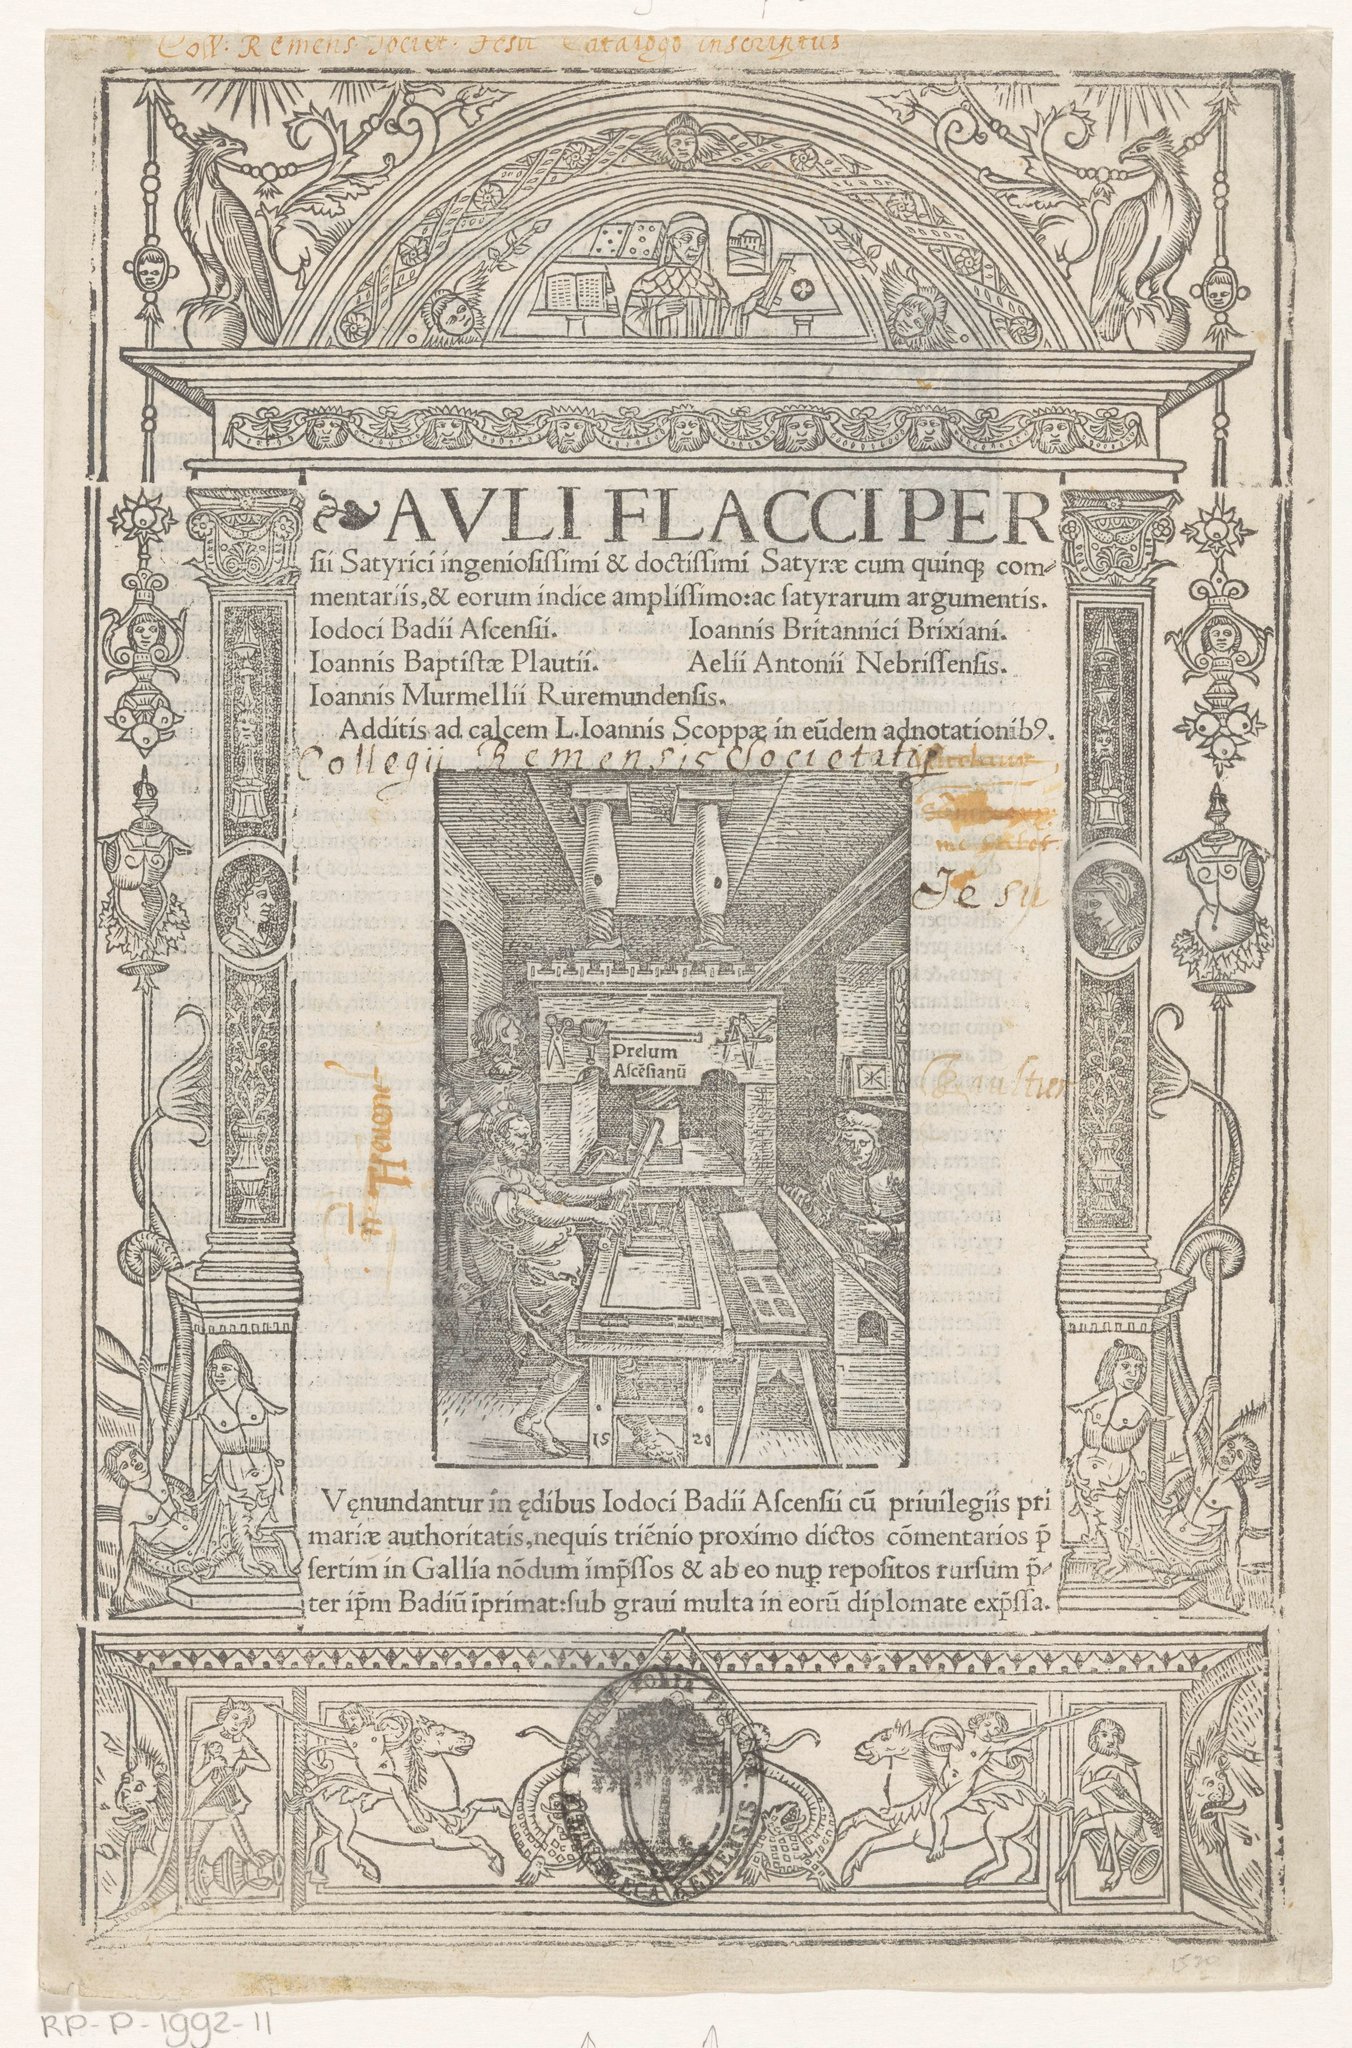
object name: titelblad, titelpagina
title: Titelpagina voor: Aules Persius Flaccus en Lucio Giovanni Scoppa, Satyrae, 1523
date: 1520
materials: paper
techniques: letterpress printing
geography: paris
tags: ornamental decoration ~ printed matter, book, device (trade-mark of printer or publisher)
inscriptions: collector's mark: ‘educuni folia [...] bibliotheca remensis’, inscription: ‘Coll. Remens. Societ. Jesu catalogo inscriptus / Collegii Remensis Societatis [...] Jesu [...]’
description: Een drukkerswerkplaats (drukkersvignet van de Parijse drukker Jodocus Badius), omgeven door een ornamentele rand.